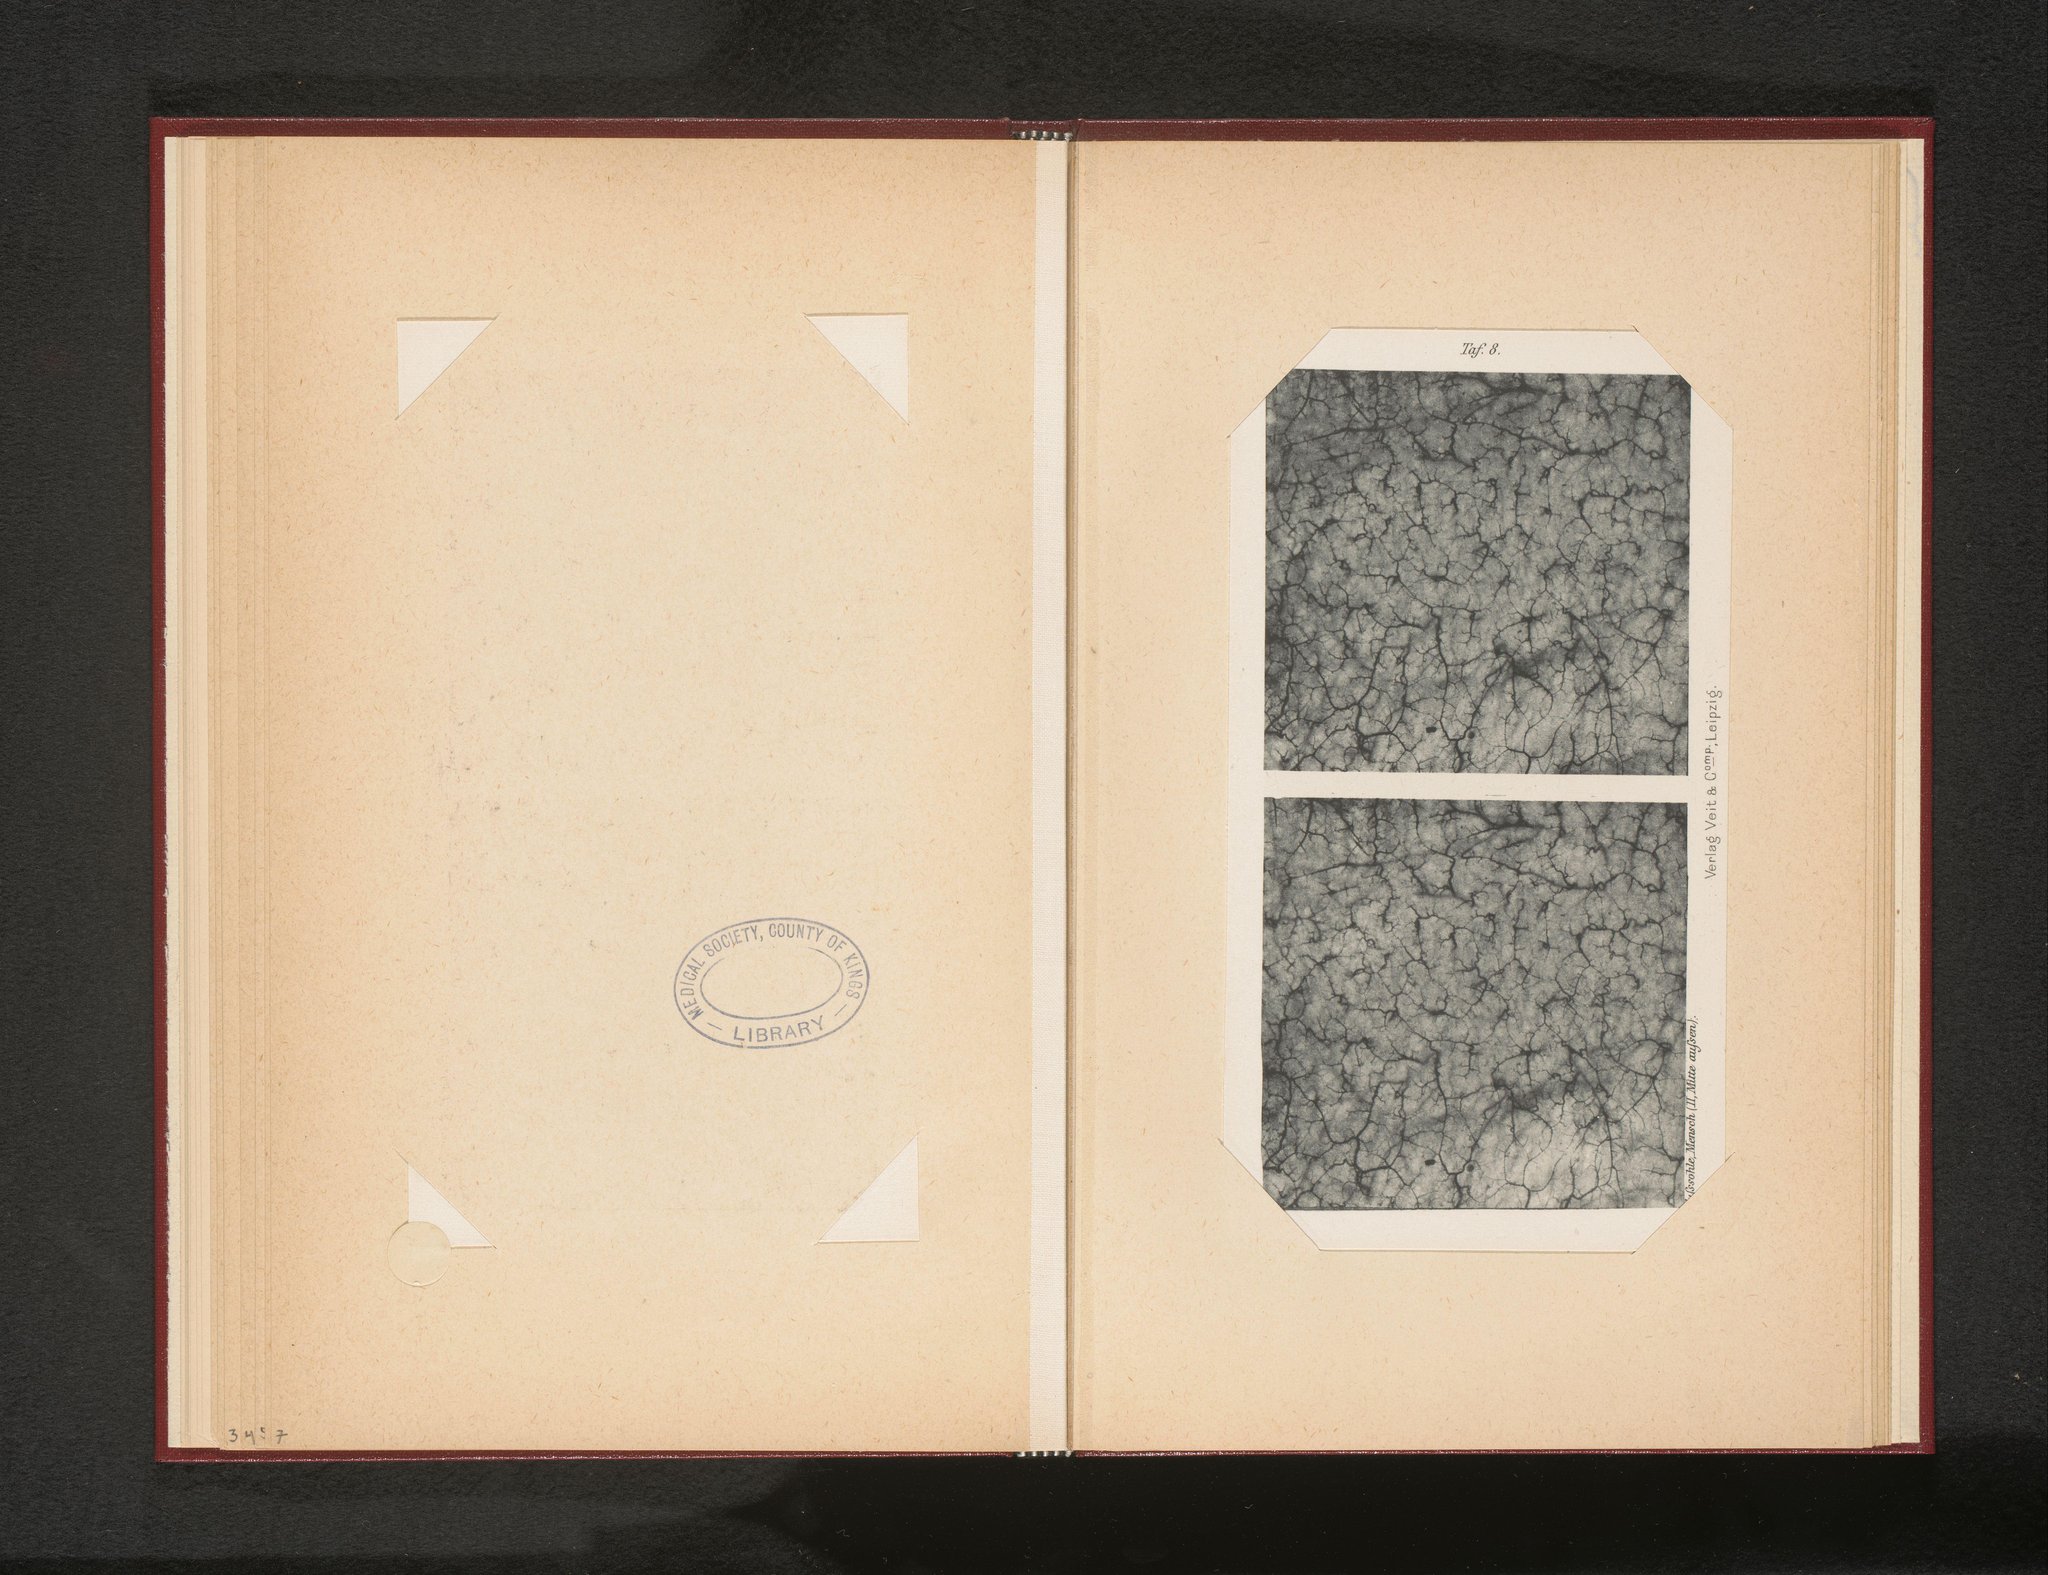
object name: stereograph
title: Fusssohle, Mensch (II, Mitte ausssen)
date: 1885-1895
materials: paper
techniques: photoaquatint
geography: vienna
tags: skin (human)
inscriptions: number: ‘Taf. 8.’